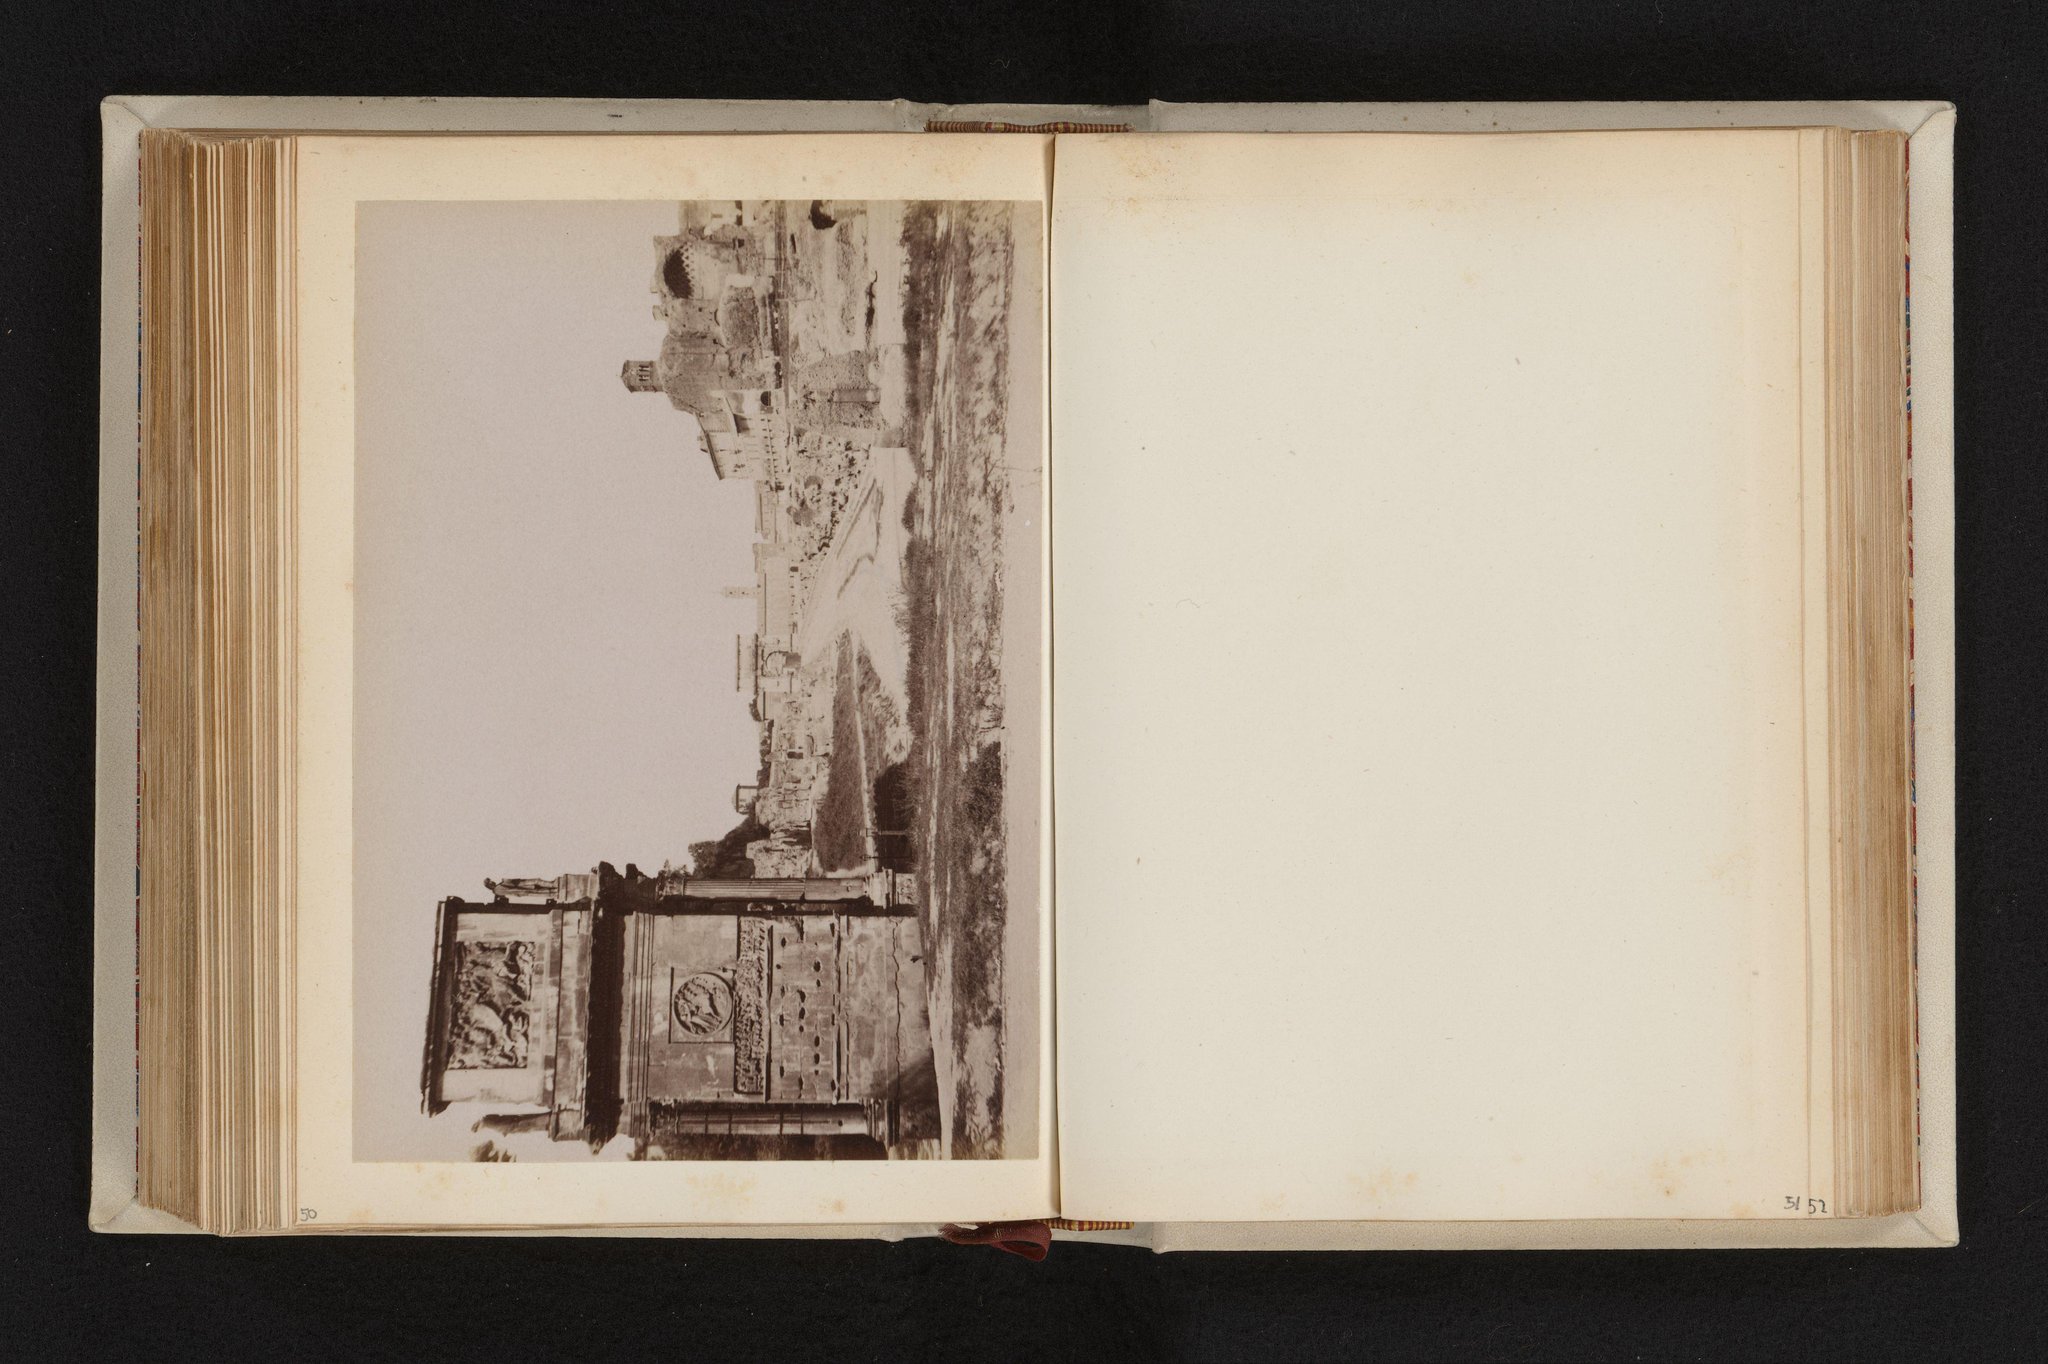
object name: photograph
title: Gezicht op de zijkant van de Boog van Constantijn in Rome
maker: Anonymous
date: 1850-1860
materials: photographic support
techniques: albumen print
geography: rome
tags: triumphal arch, arch of constantine